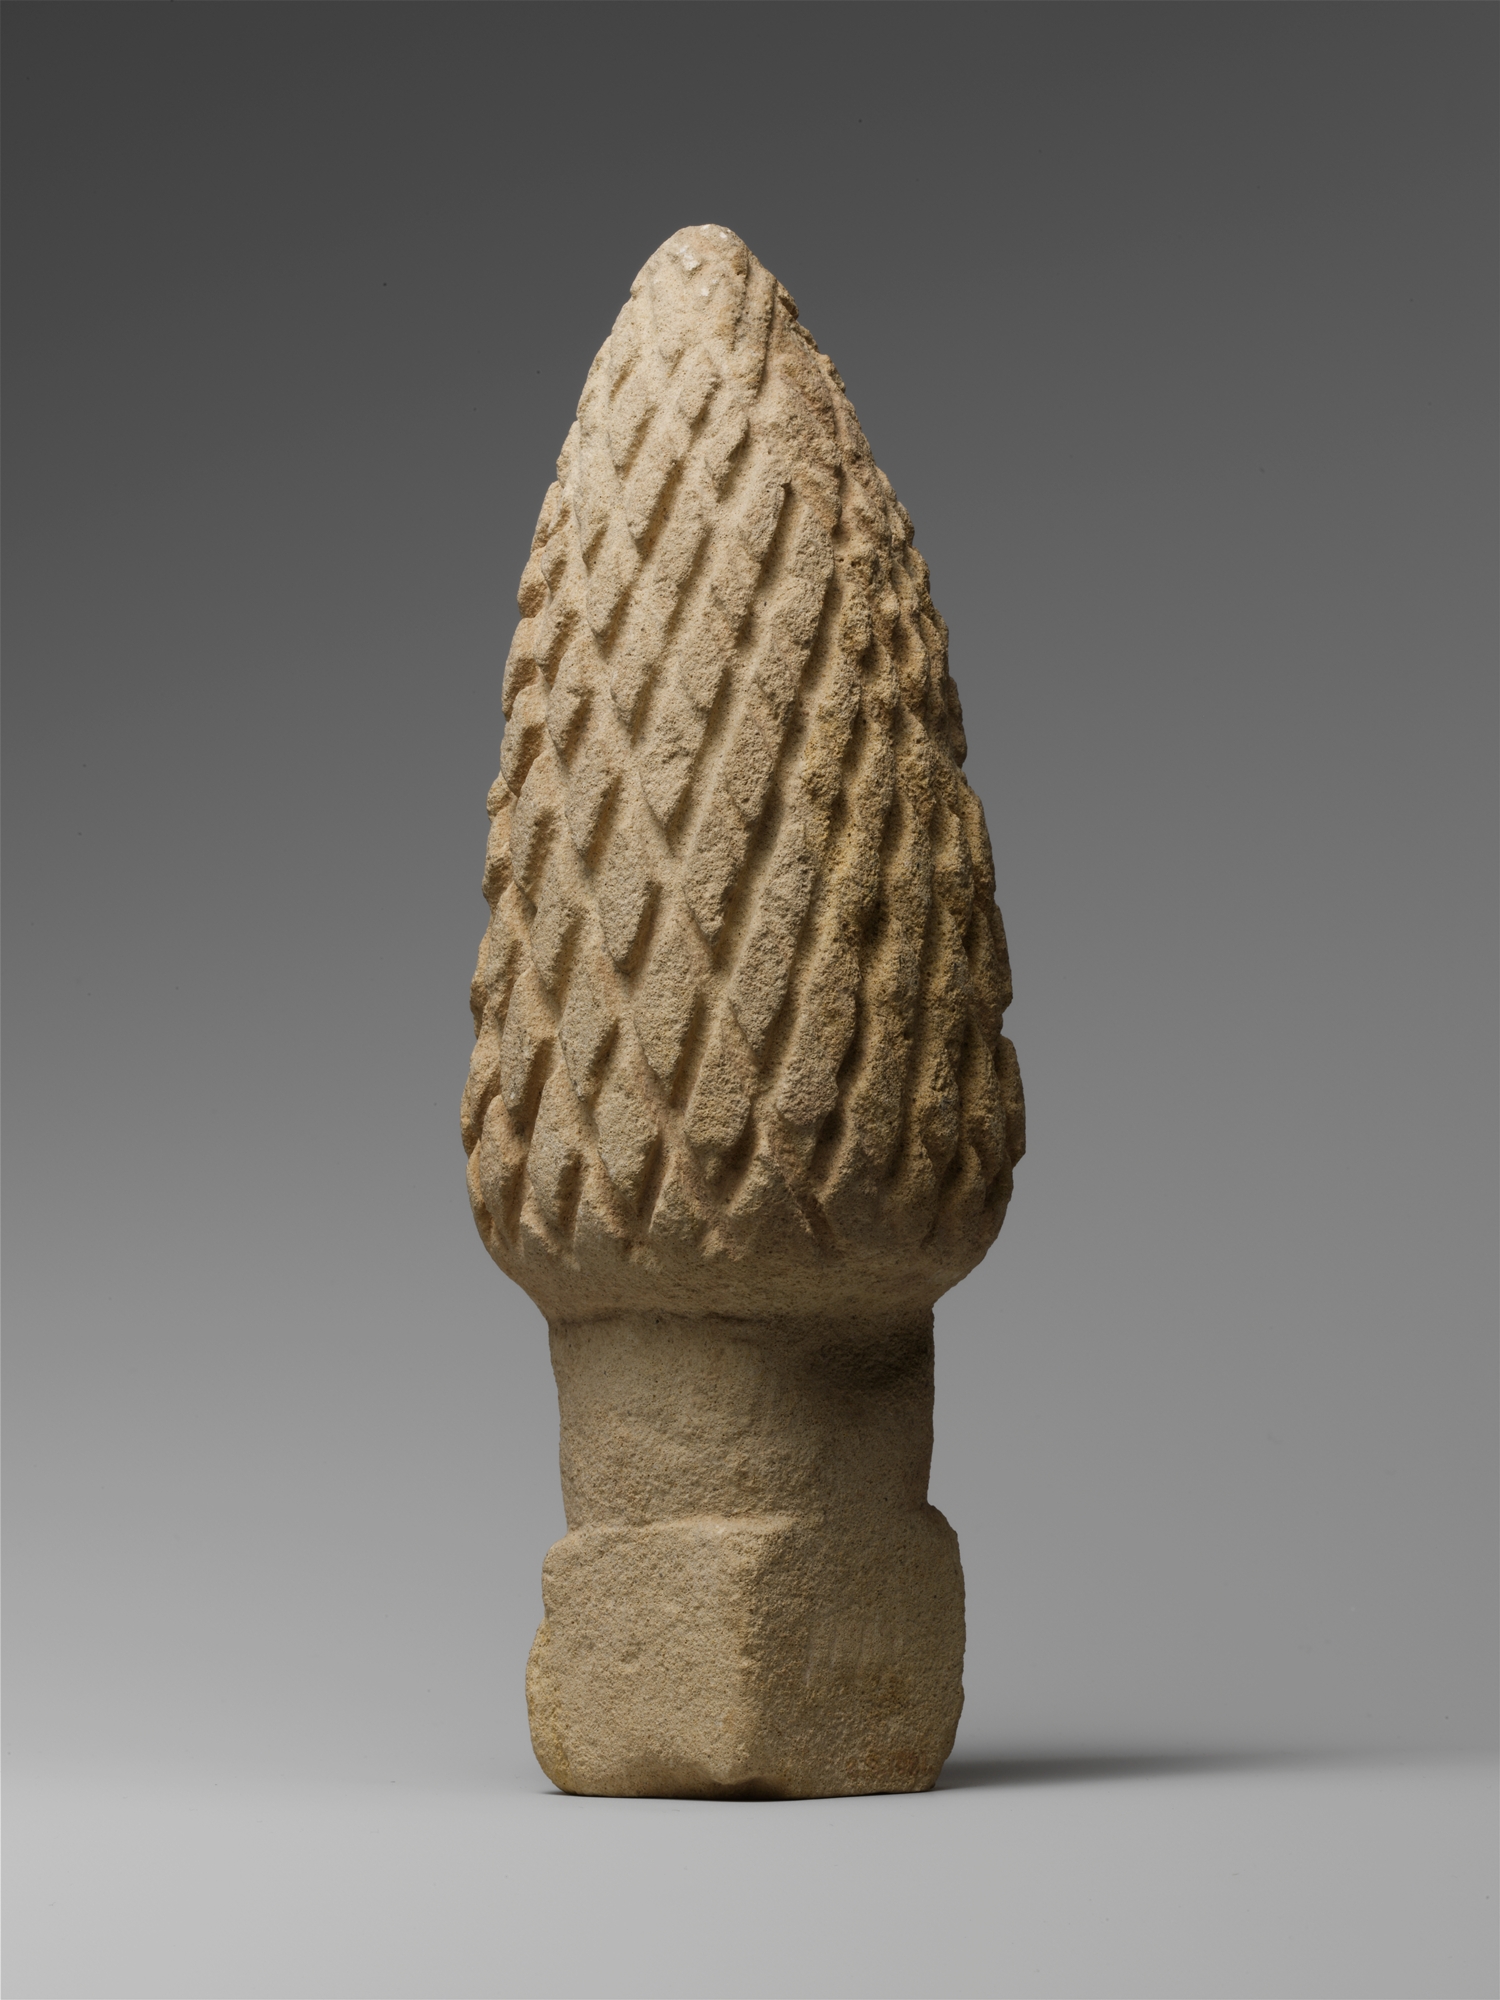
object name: votive pine cone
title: Limestone votive pine cone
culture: cypriot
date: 300-1 BCE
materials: limestone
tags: pinecones